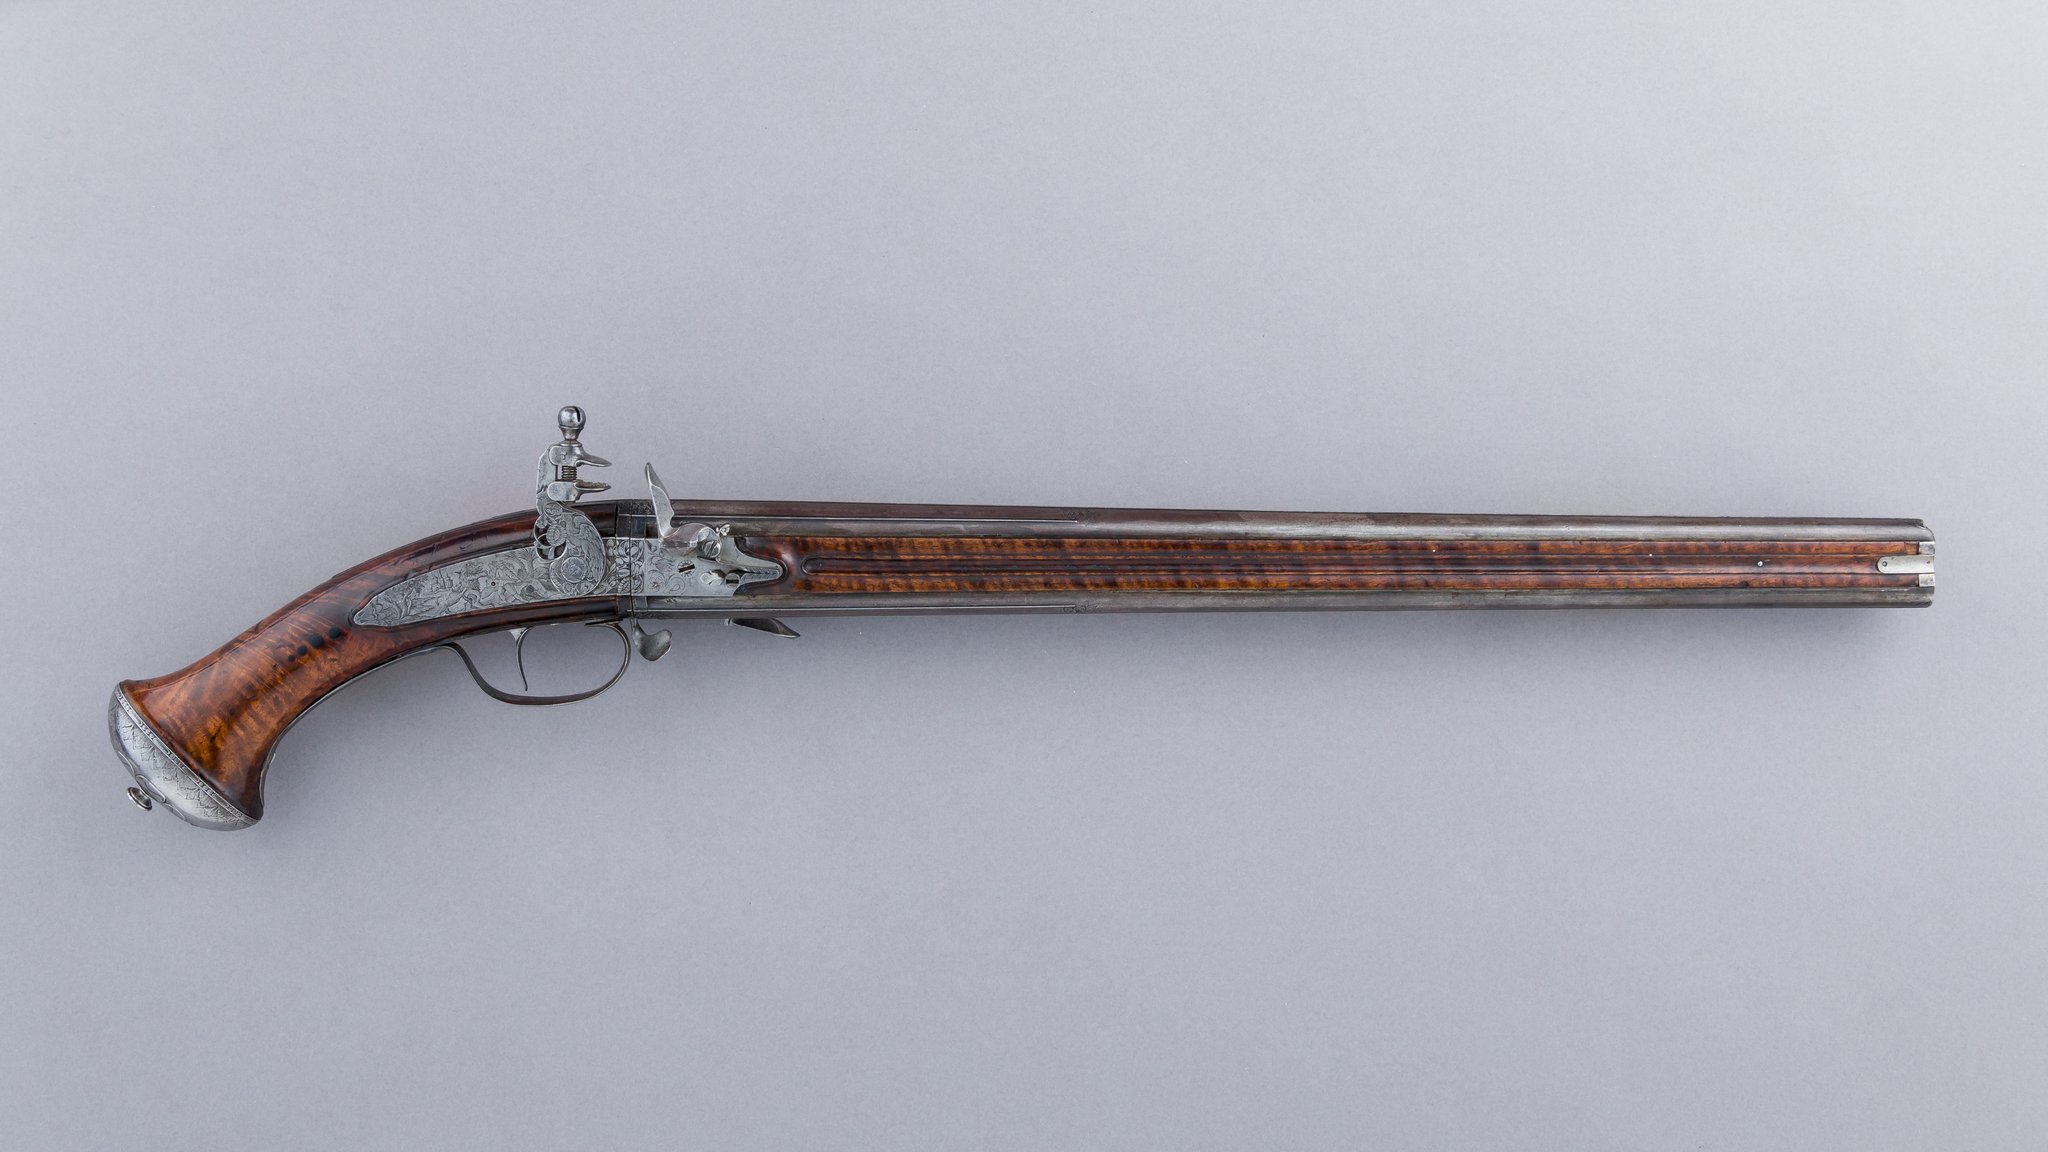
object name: flintlock wender pistol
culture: french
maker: claude cunet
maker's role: gunsmith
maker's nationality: french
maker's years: 1625-1675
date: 1650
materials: iron, steel, wood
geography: france